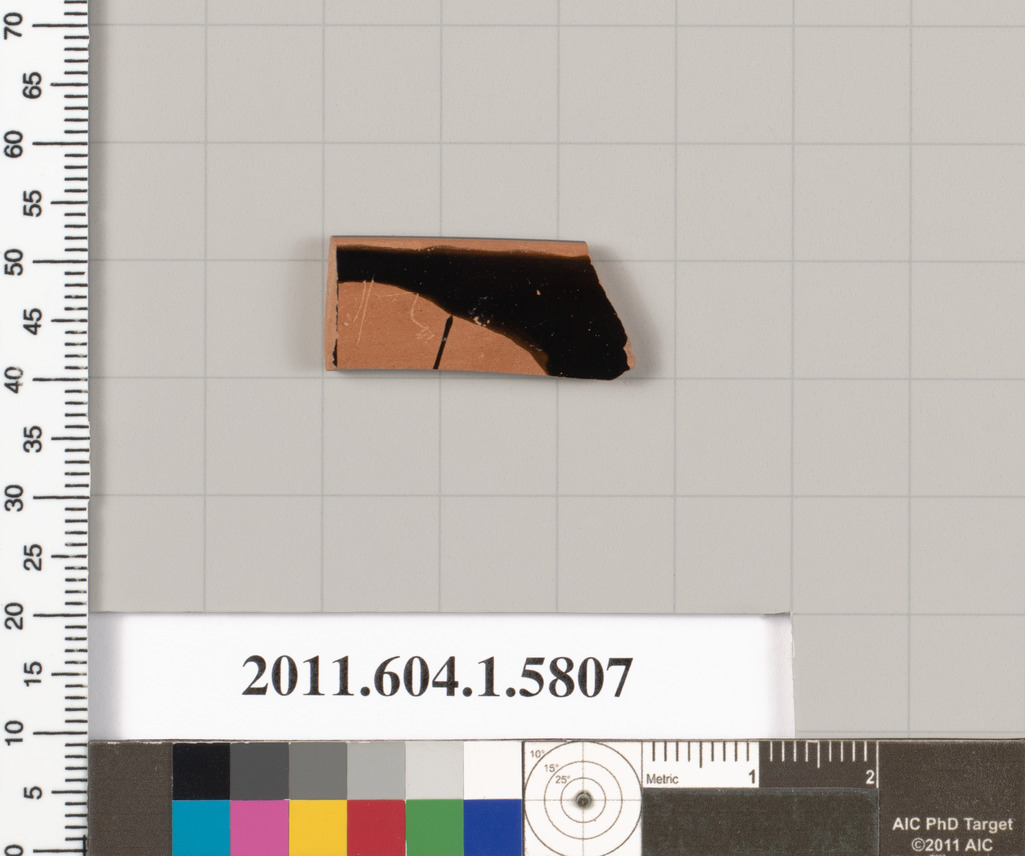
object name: kylix fragment, eye cup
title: Terracotta rim fragment of a kylix: eye-cup (drinking cup)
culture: greek, attic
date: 520-510 BCE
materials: terracotta